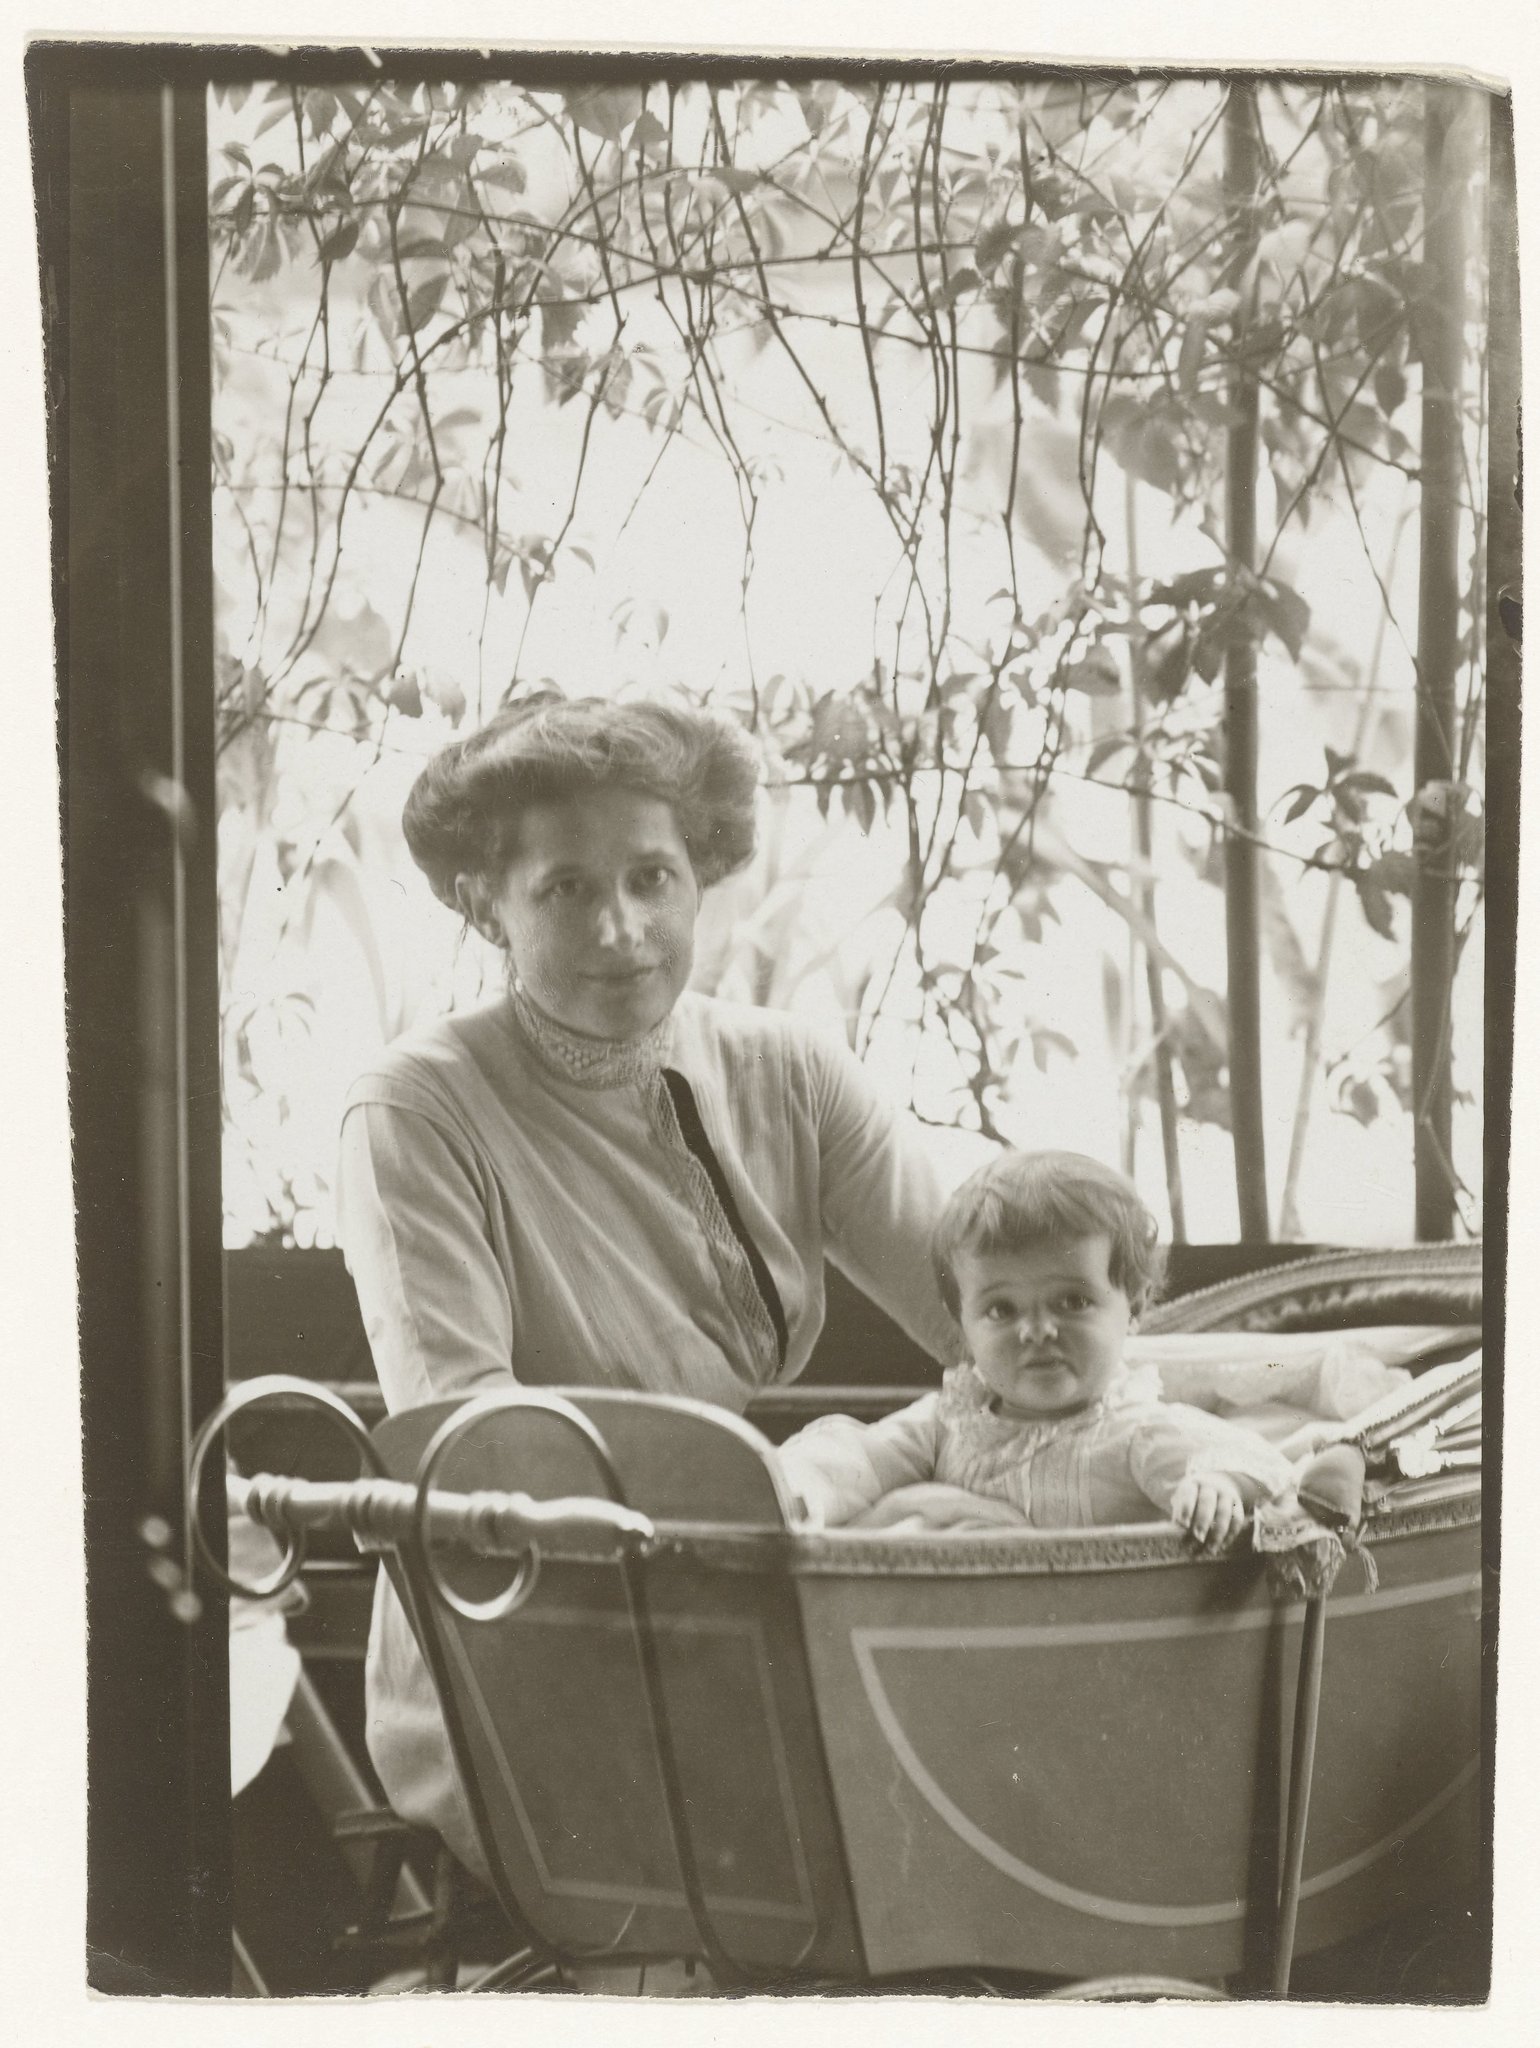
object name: photograph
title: Olga en Marba Titzenthaler, echtgenote en dochter van de fotograaf, in het woonhuis in de Friedrichstrasse, Berlijn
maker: waldemar titzenthaler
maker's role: fotograaf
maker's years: 1869-1937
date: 1912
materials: paper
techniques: gelatin silver print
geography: berlin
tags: mother and baby or young child, mother and child(ren), woman and child(ren) (family group), berlin